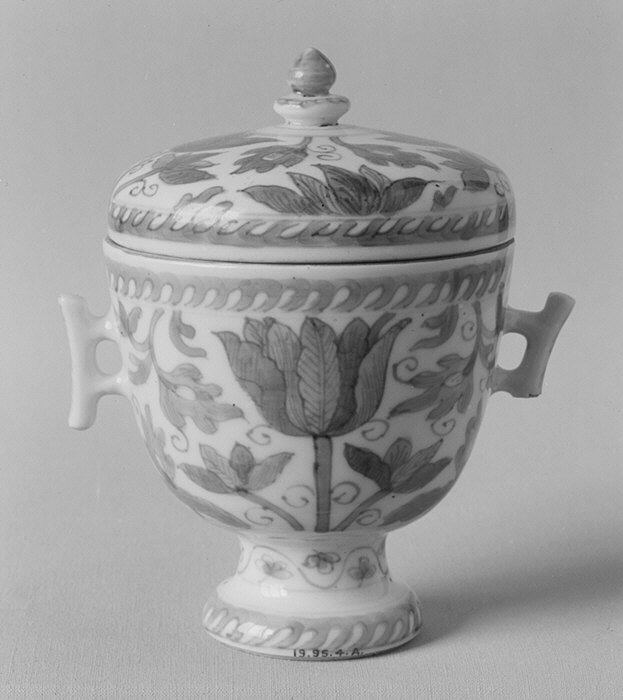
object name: cup with cover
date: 1700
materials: hard paste porcelain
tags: flowers